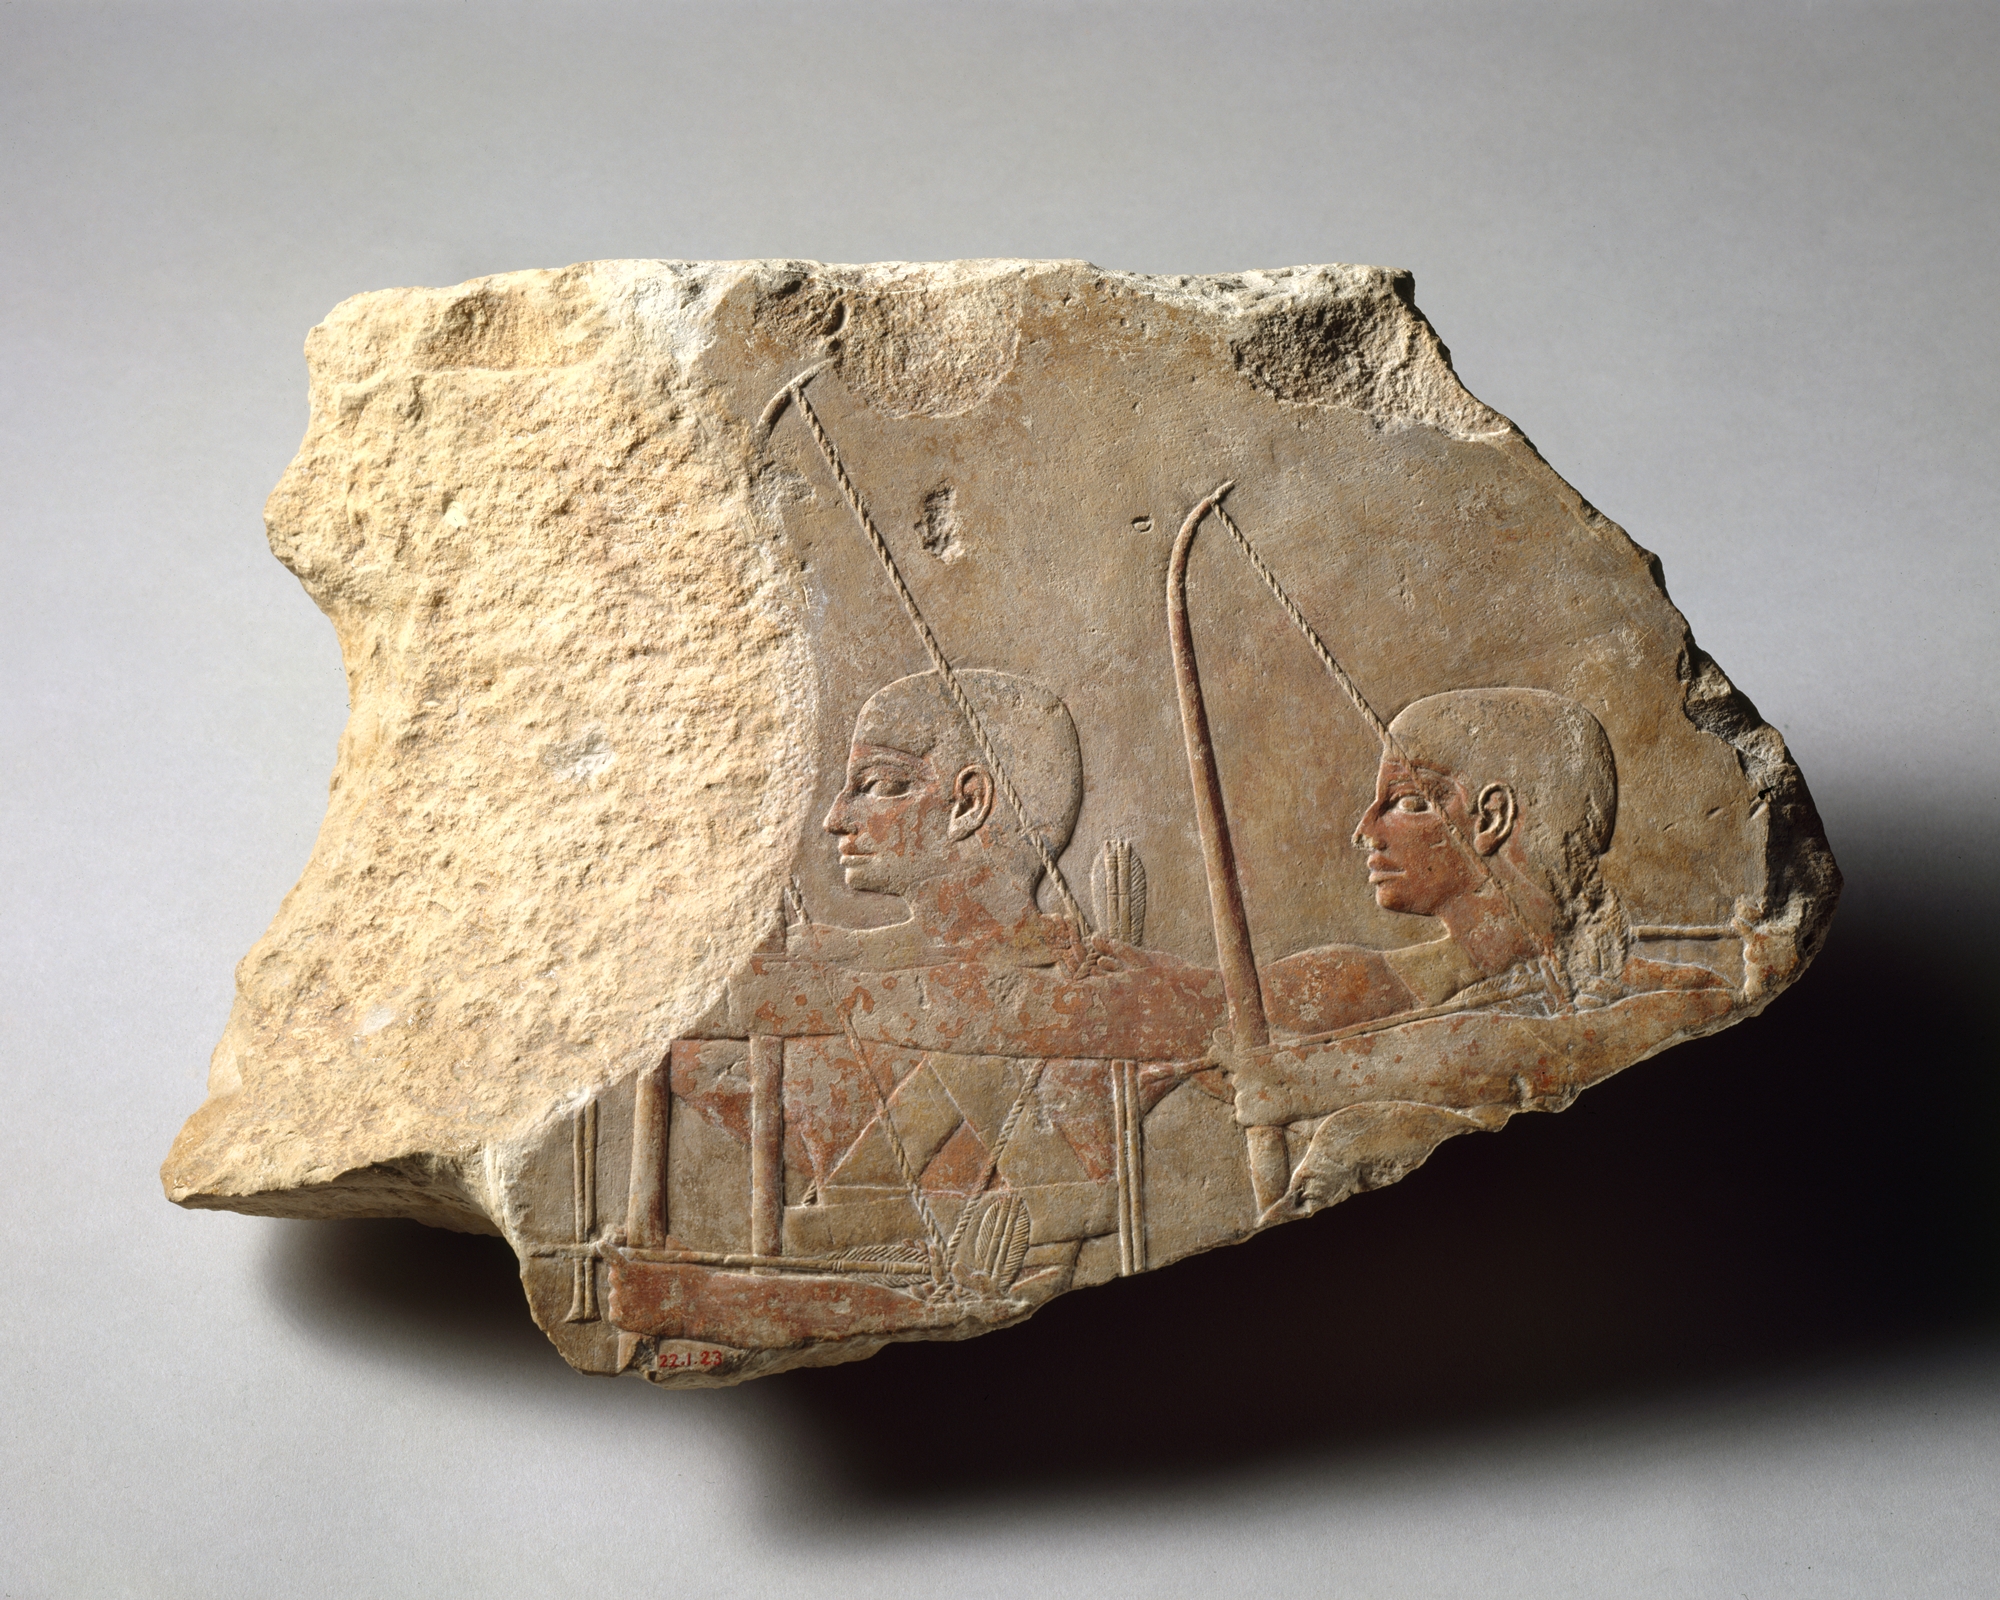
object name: relief, archer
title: Archers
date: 2551-2494 BCE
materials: limestone, paint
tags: men,archery